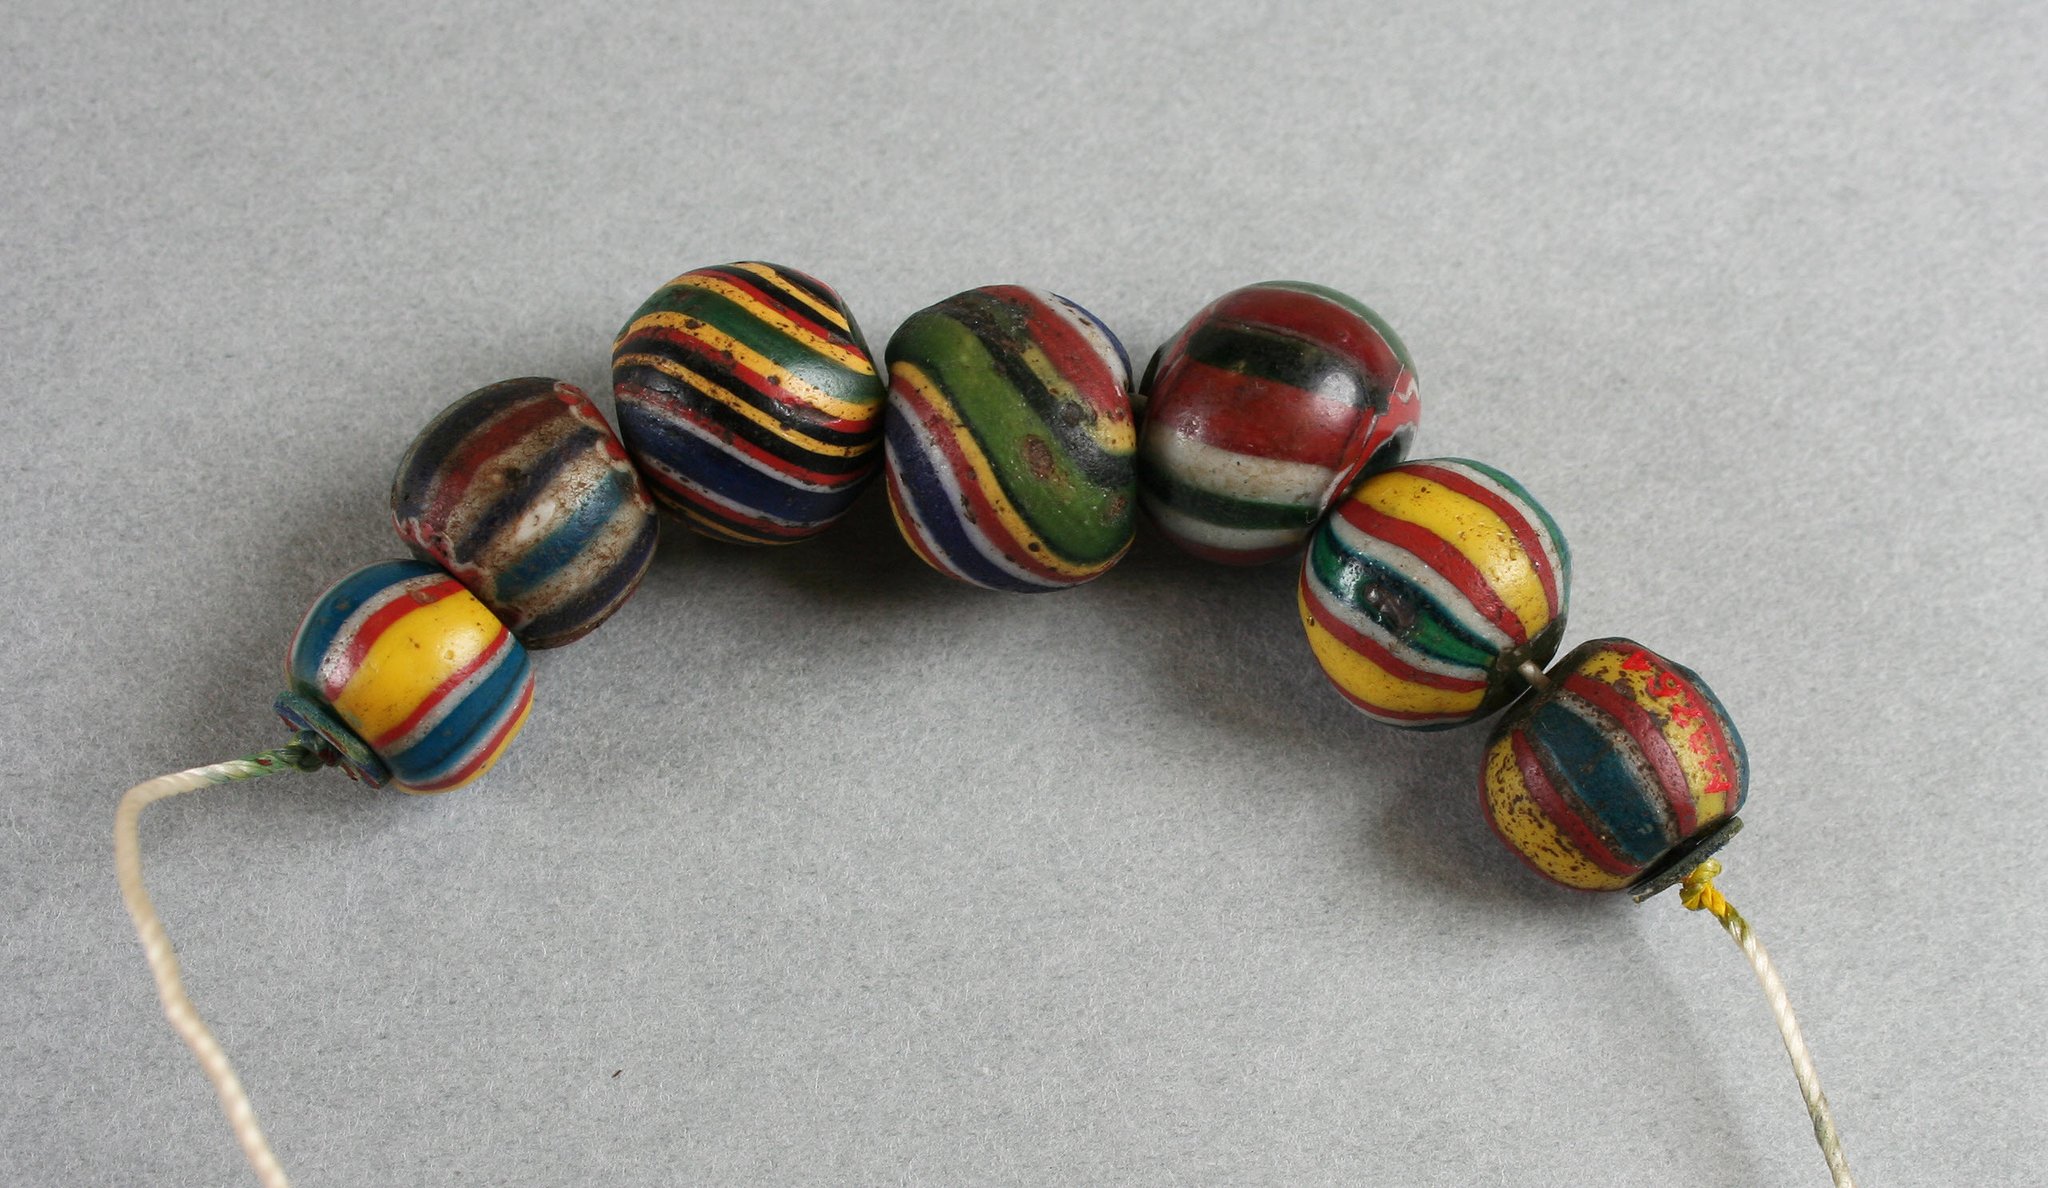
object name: bead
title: Beads, string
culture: african or european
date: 1701-1800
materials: glass